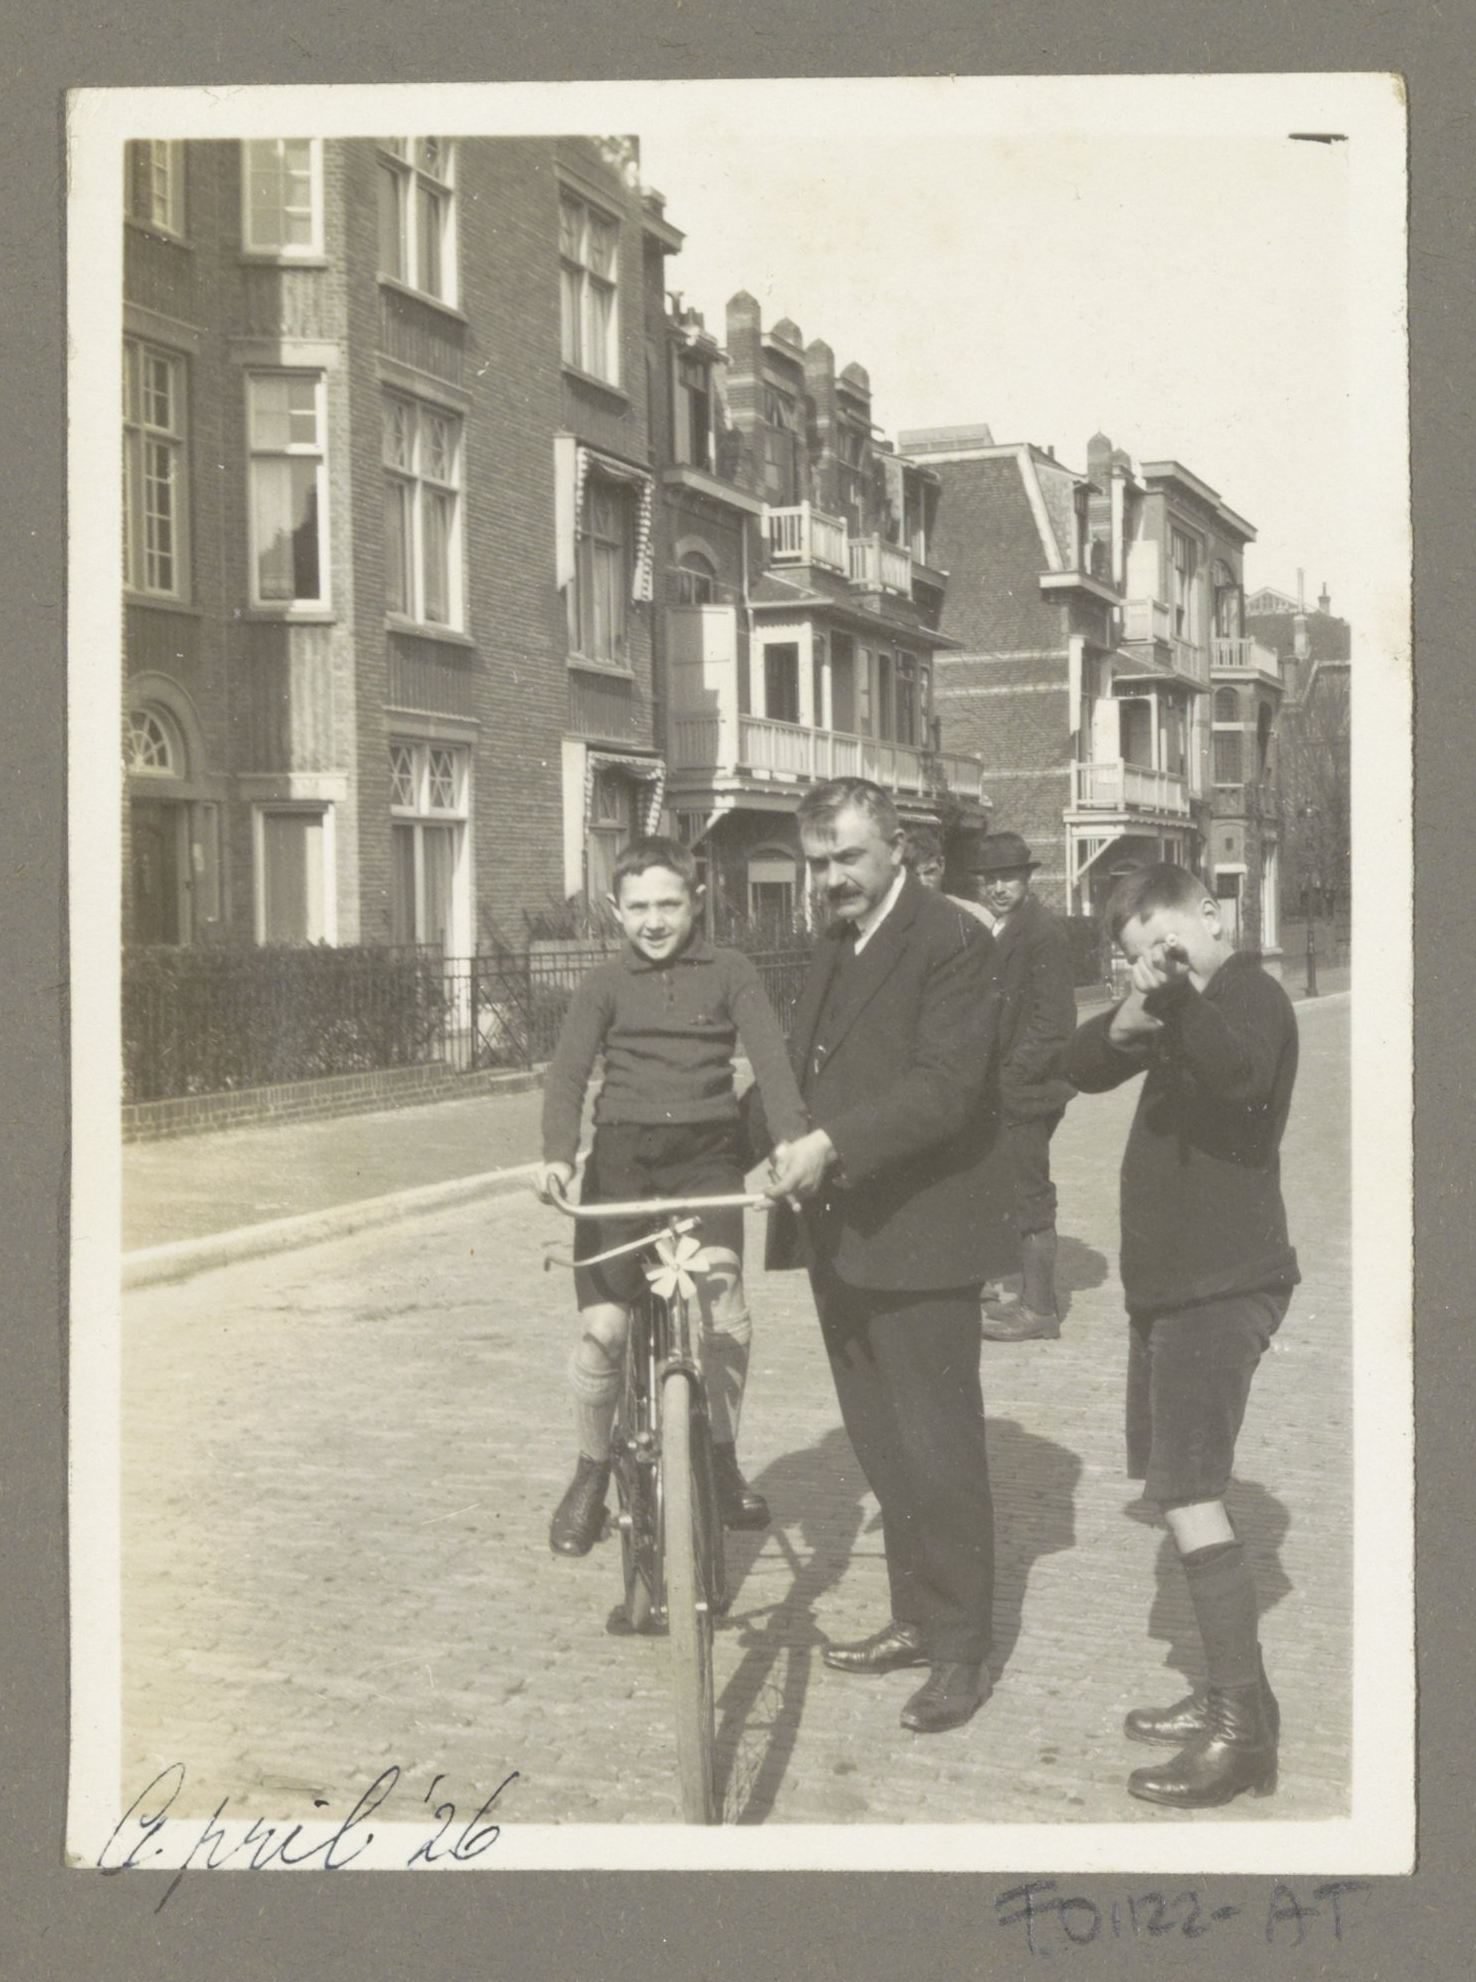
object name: photograph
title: Man met (vermoedelijk) Hans en Georges Bersgma bij een fiets op straat in Nederland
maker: Anonymous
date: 1904-1926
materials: photographic support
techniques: gelatin silver print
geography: netherlands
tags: utrecht, bicycle, father and child(ren), man and child(ren) (family group), street (+ city(-scape) with figures, staffage), netherlands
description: Onderdeel van fotoalbum met opnames van de familie Bergsma in Tandjong Poera en Rantan Pandjang (Sumatra).